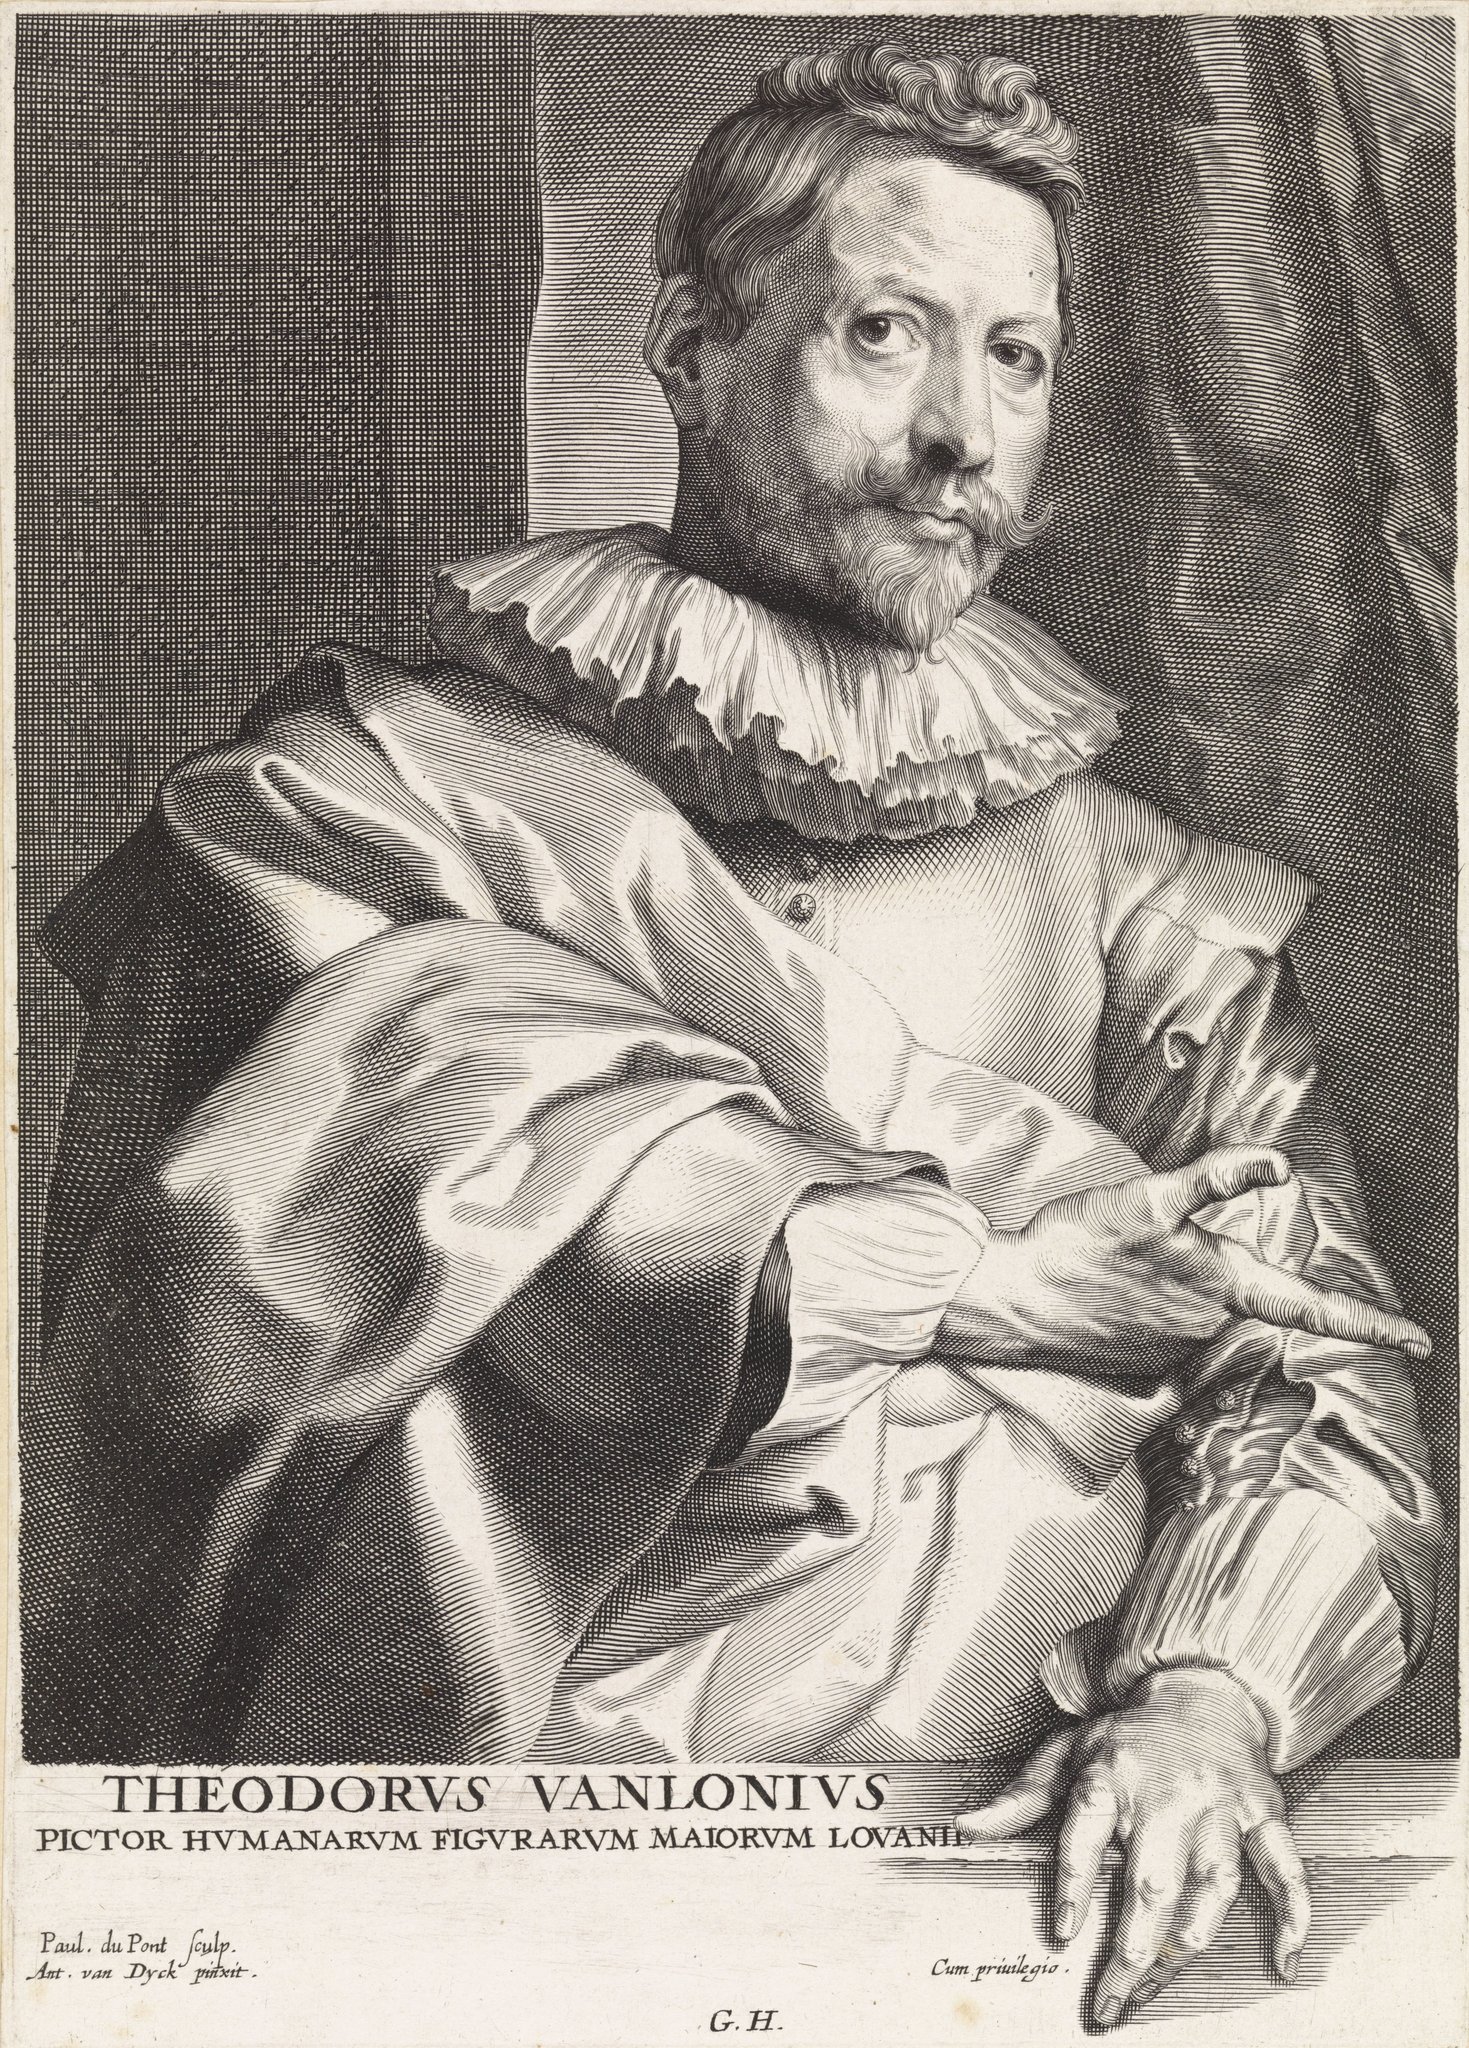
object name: print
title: Portret van de schilder Theodoor van Loon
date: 1616-1657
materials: paper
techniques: engraving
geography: antwerp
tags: louvain, painter, theodoor van loon, portrait, self-portrait of painter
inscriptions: collector's mark: Lugt 240